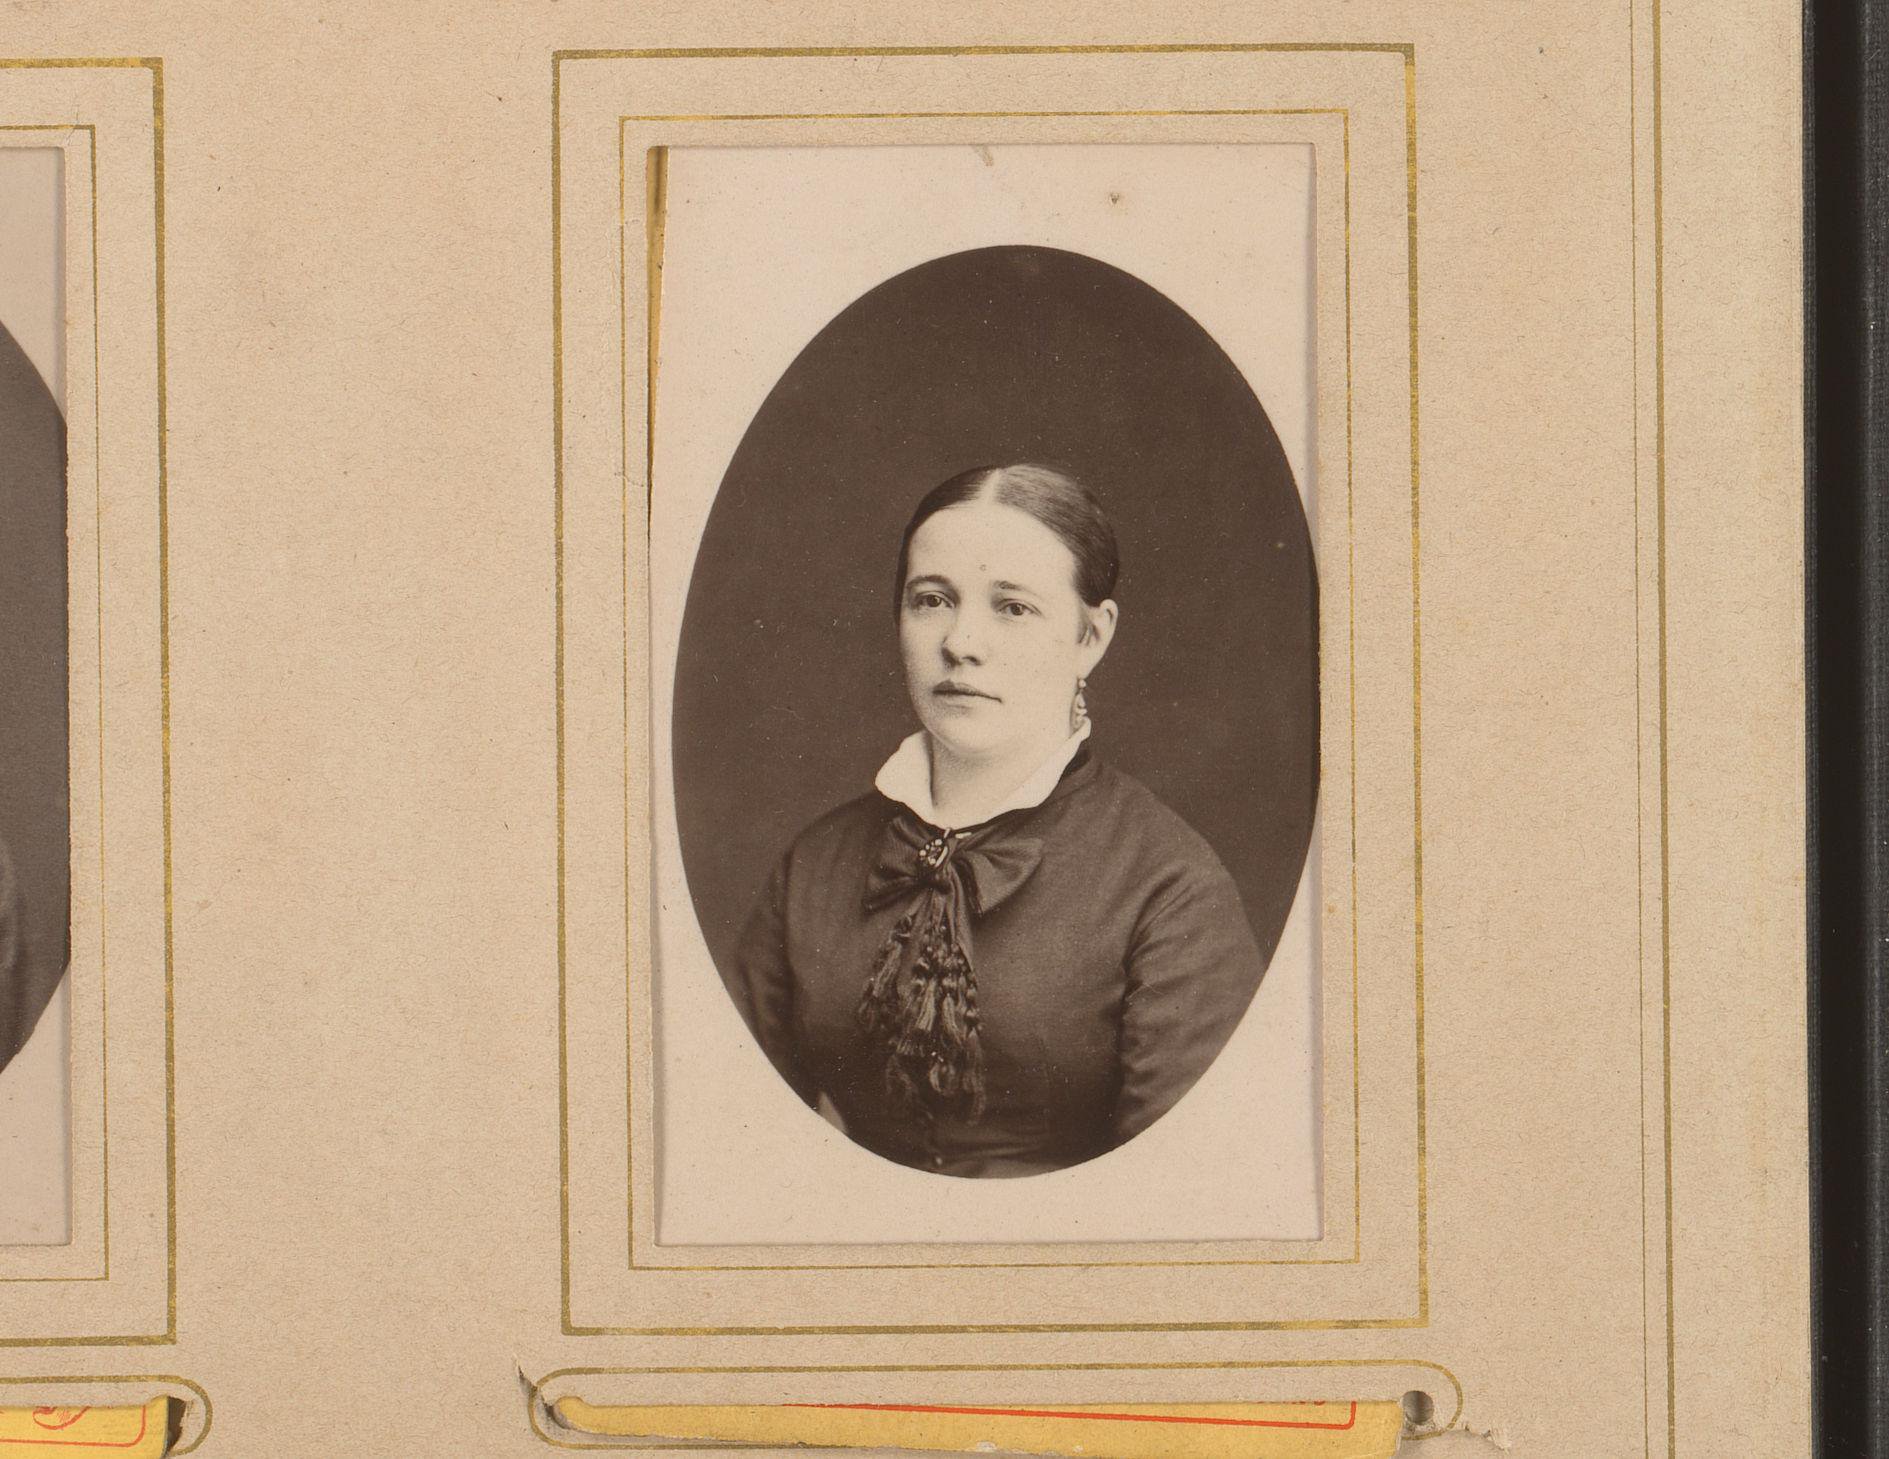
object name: photograph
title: Portret van een vrouw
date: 1875-1899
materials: cardboard, celluloid, photographic support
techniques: albumen print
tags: adult woman, historical persons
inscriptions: name: ‘Cornand et Cie Gand’, inscription: ‘Gand/ Rue de la Corne, 1 & Rue des douze Chambres, 15 (...)’